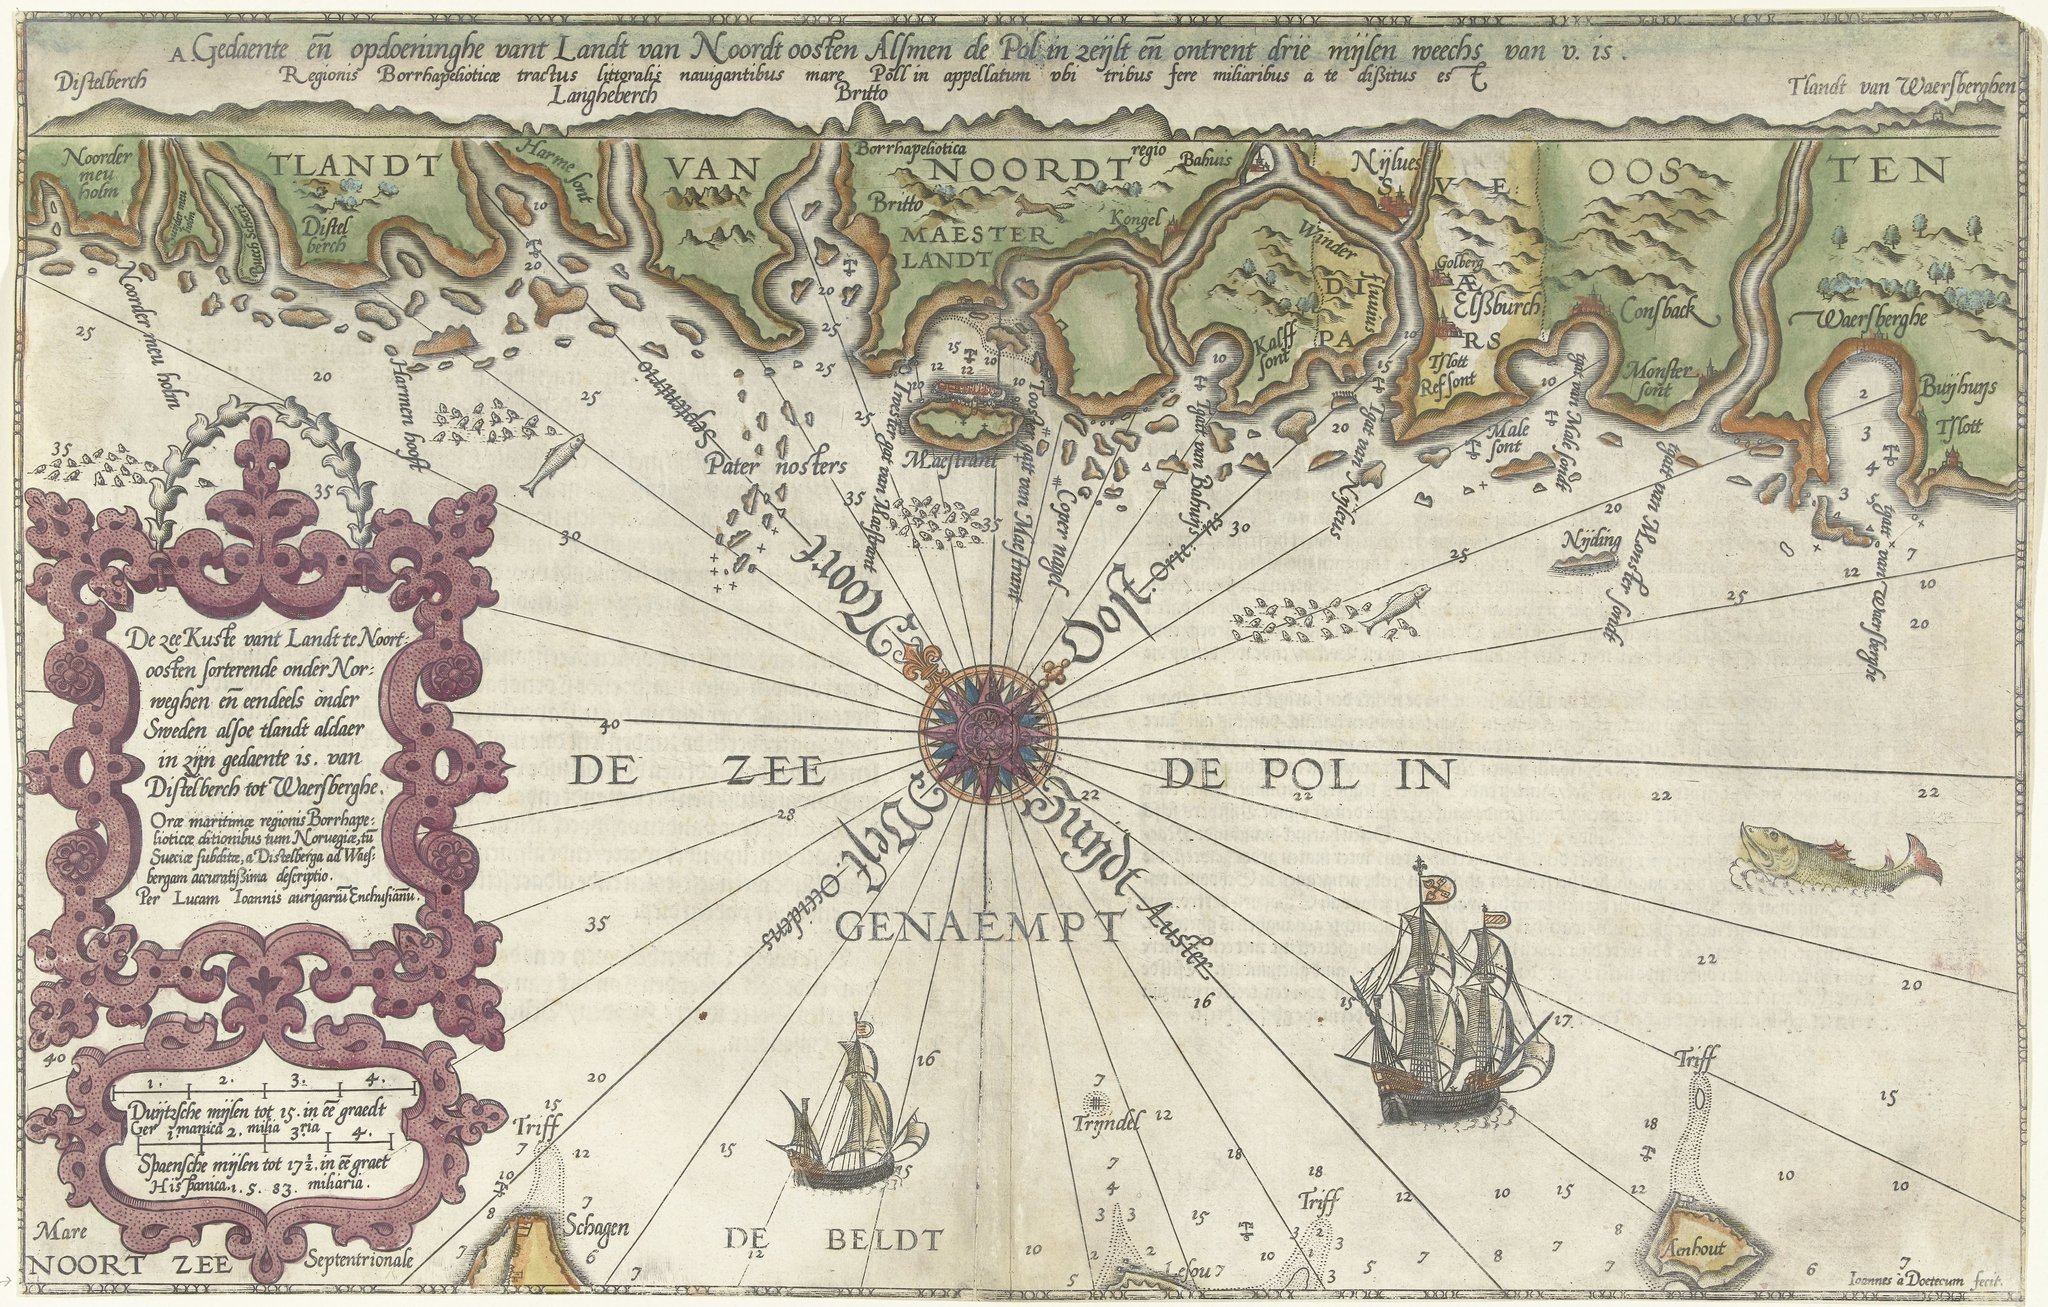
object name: map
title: De zee Kuste vant Landt te Noortoosten sorterende onder Norweghen ende eendeels onder Sweden (...)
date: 1580-1583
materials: paper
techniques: engraving, hand coloring, letterpress printing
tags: representation of last judgement, with the archangel michael weighing the souls (or dividing the blessed and the damned), norway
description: Kaart voor: L.J. Waghenaer. Spieghel der Zeevaerdt. Leiden: C. Plantijn, 1584-1605. Verschillende uitgaven.